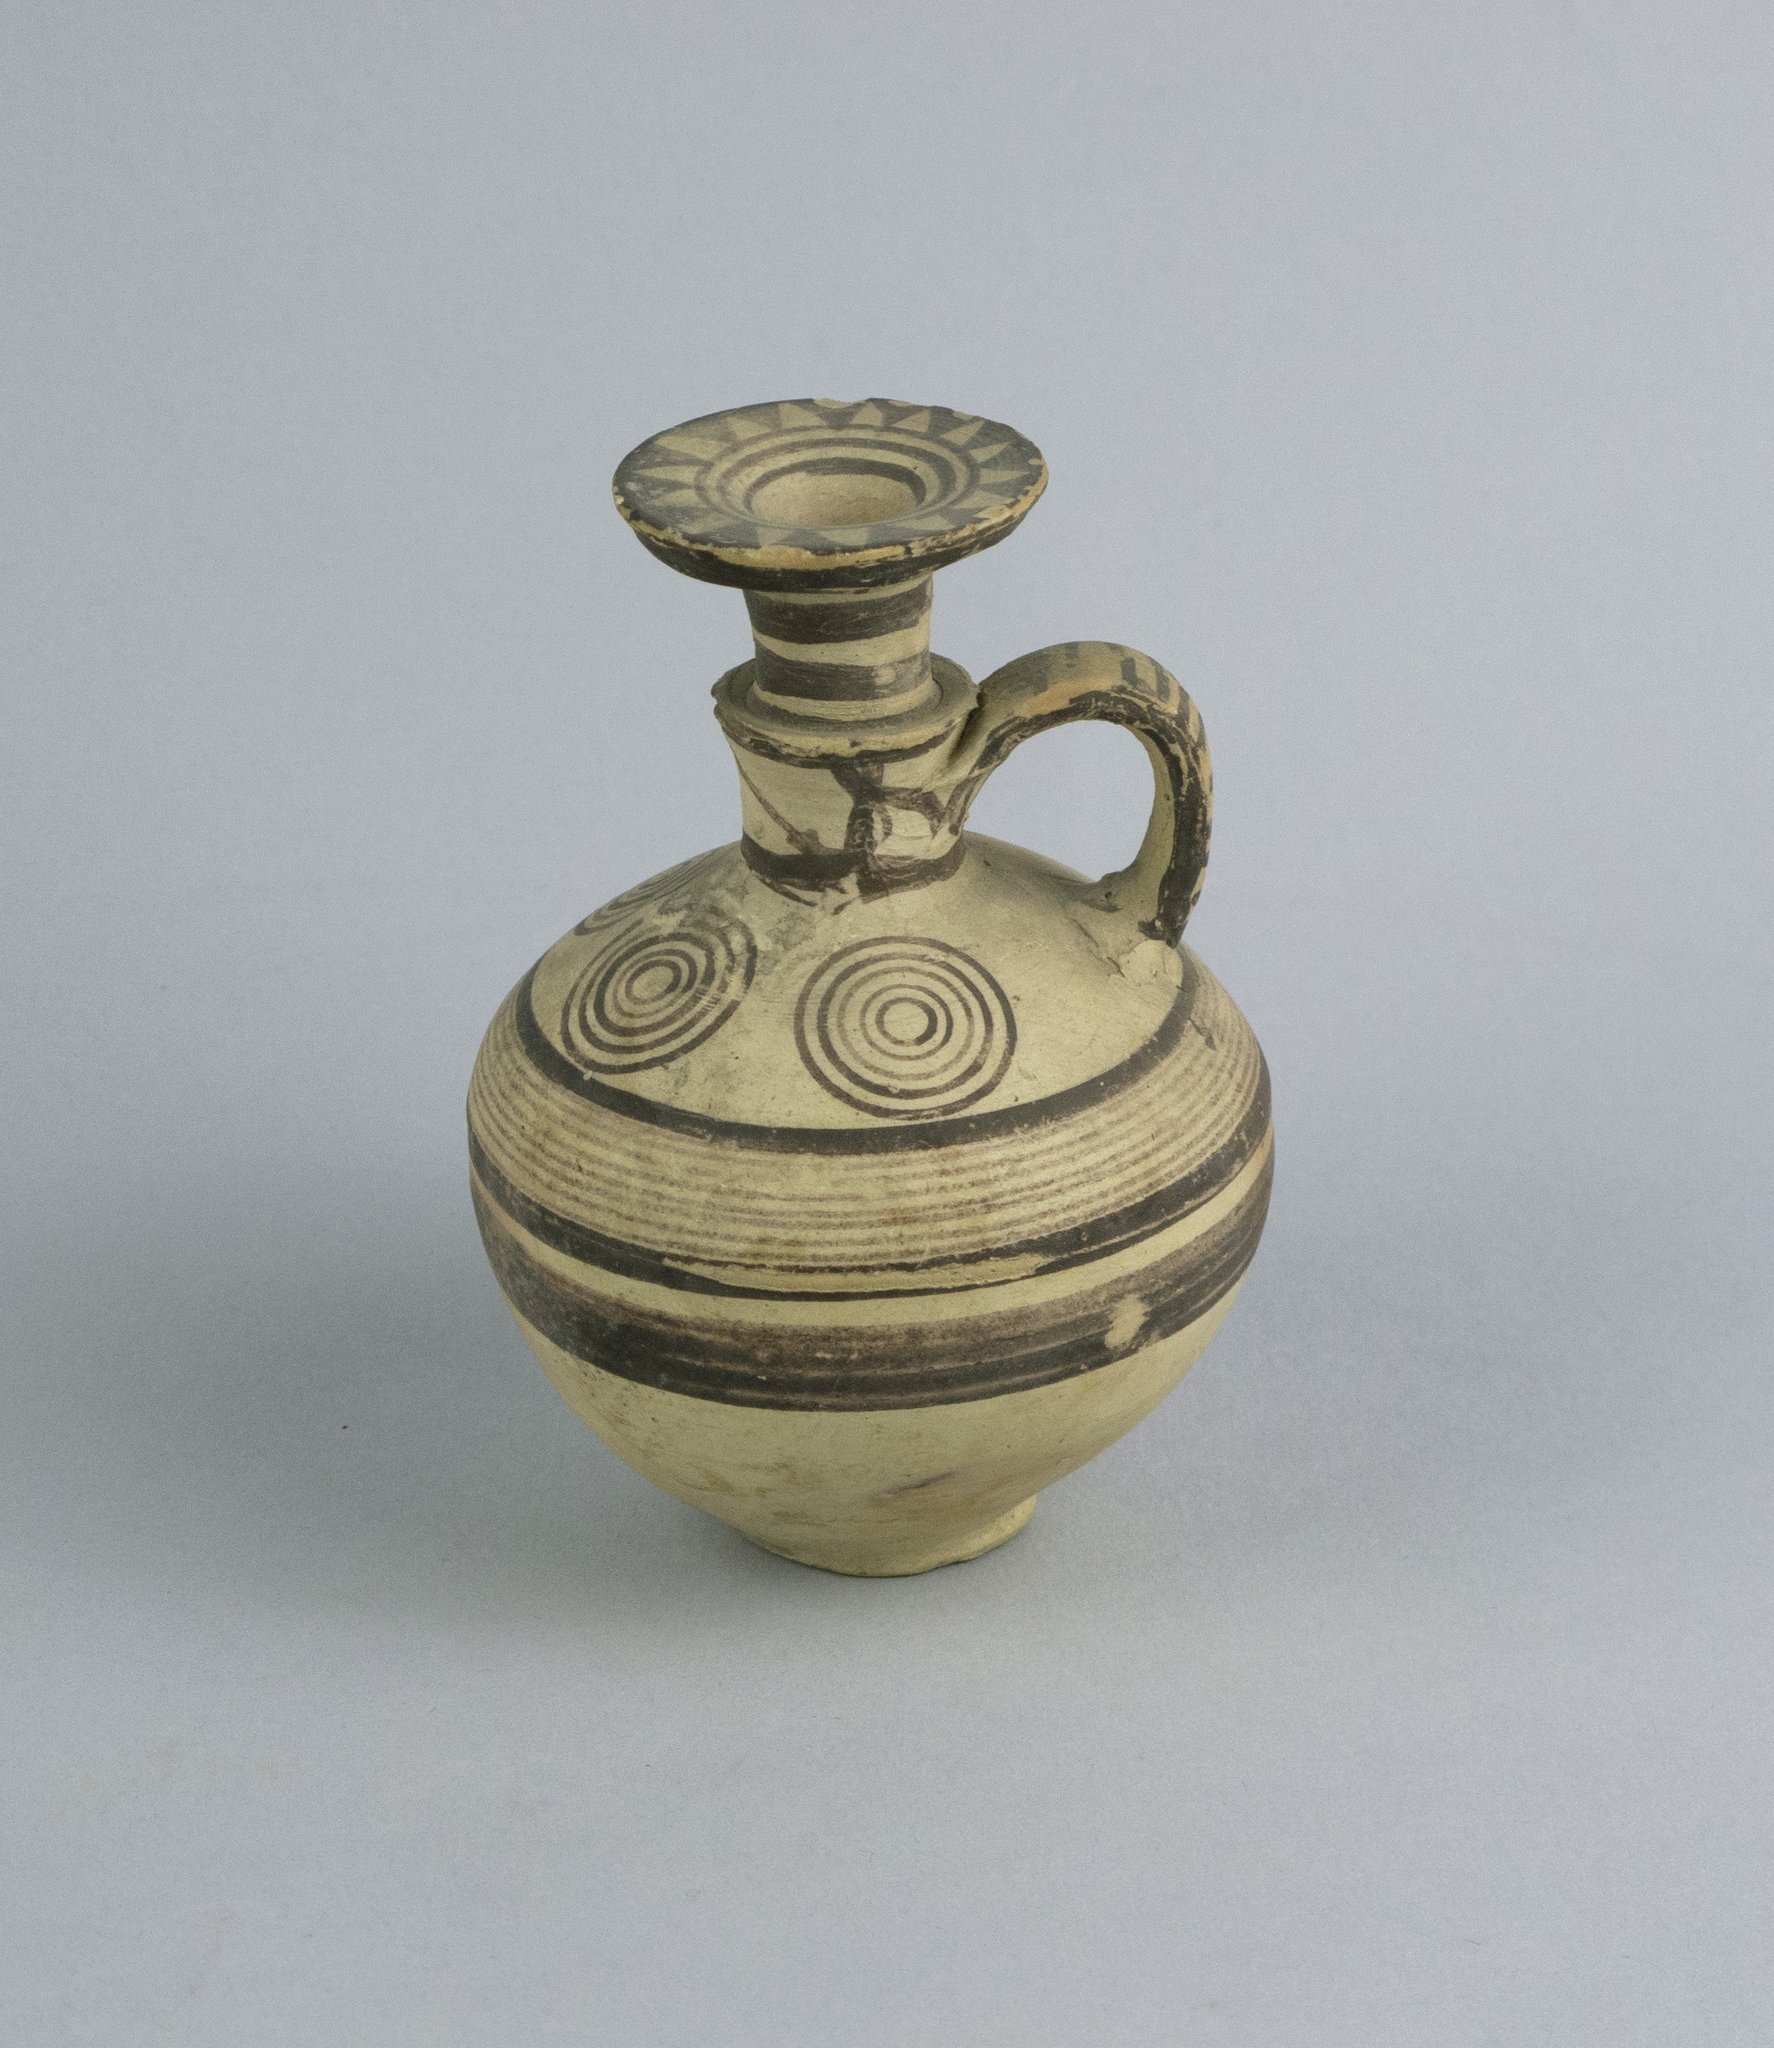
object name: jug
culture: cypriot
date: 1125-1050 BCE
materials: terracotta